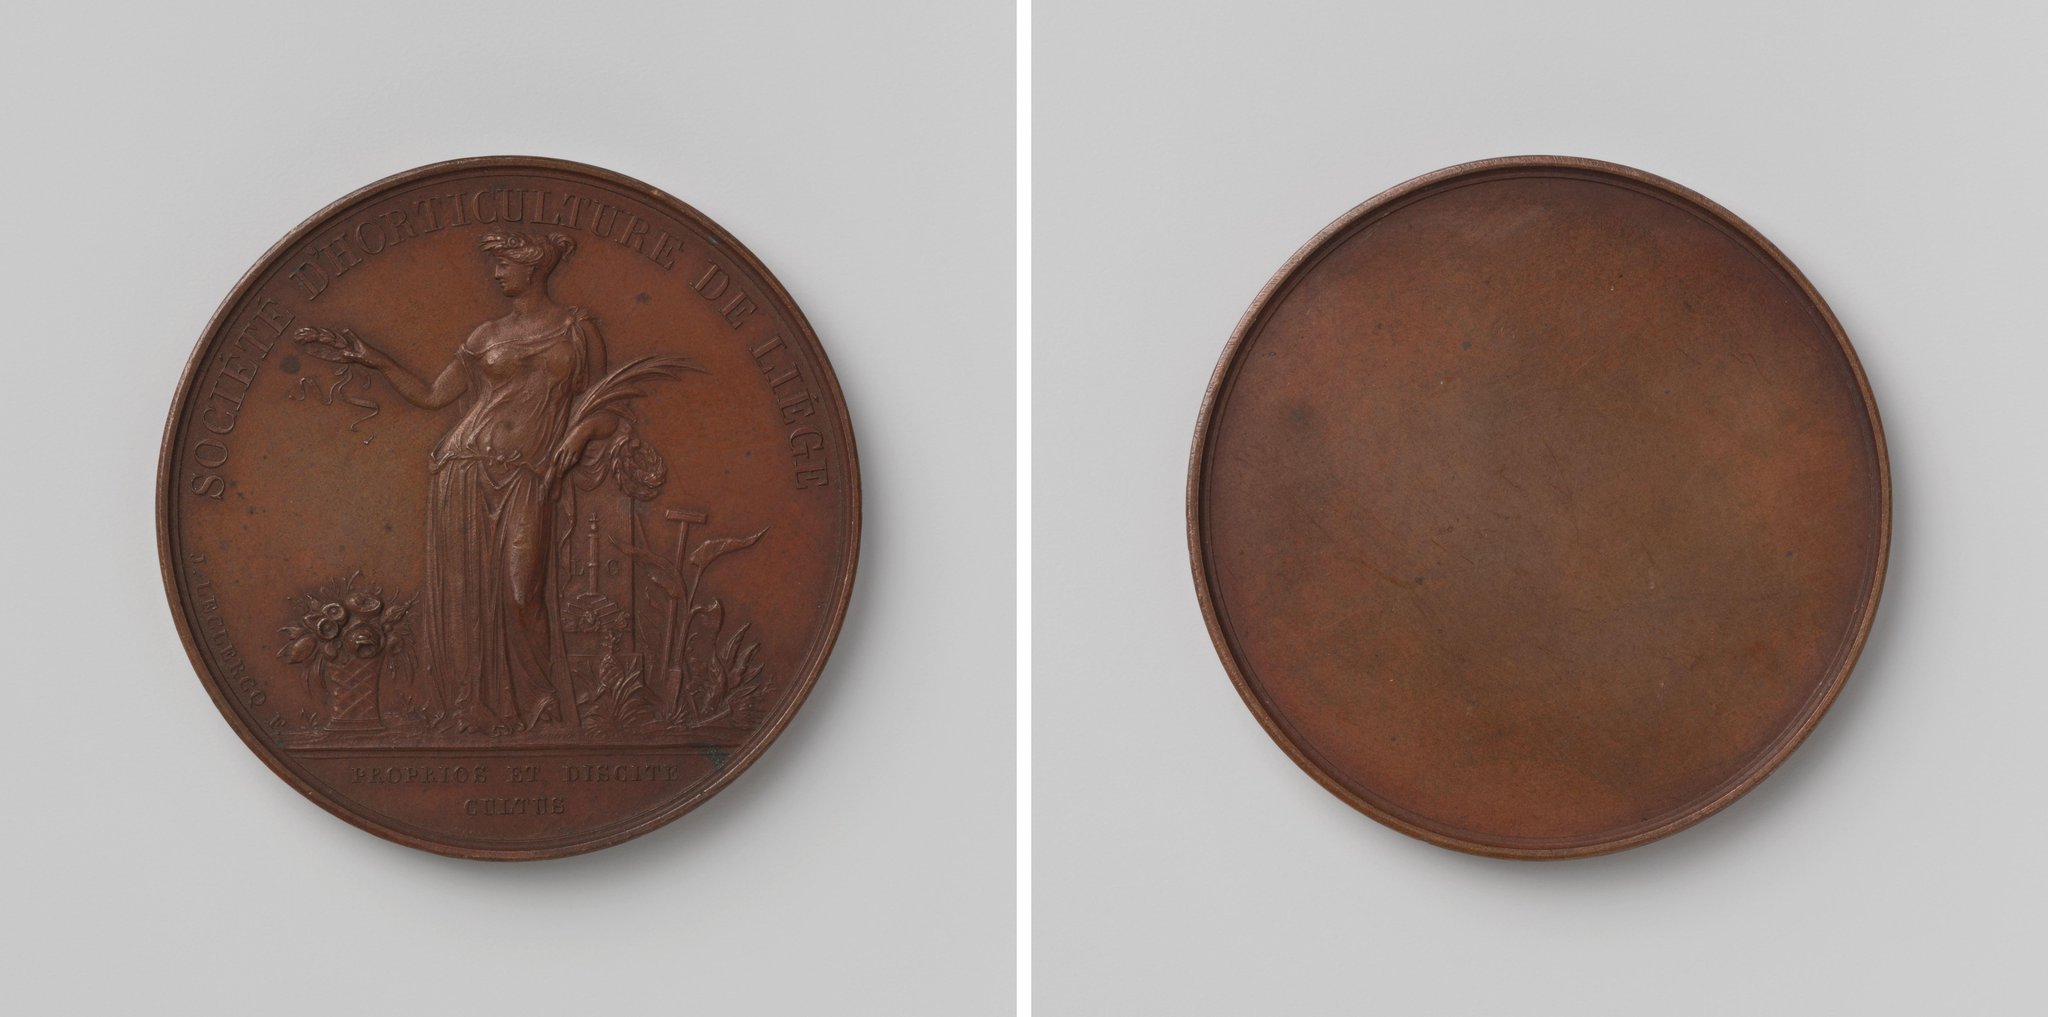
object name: medal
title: Societe d'Horticulture te Luik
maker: julien gabriel leclercq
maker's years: 1805-1882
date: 1825-1850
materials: bronze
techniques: striking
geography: brussels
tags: liège